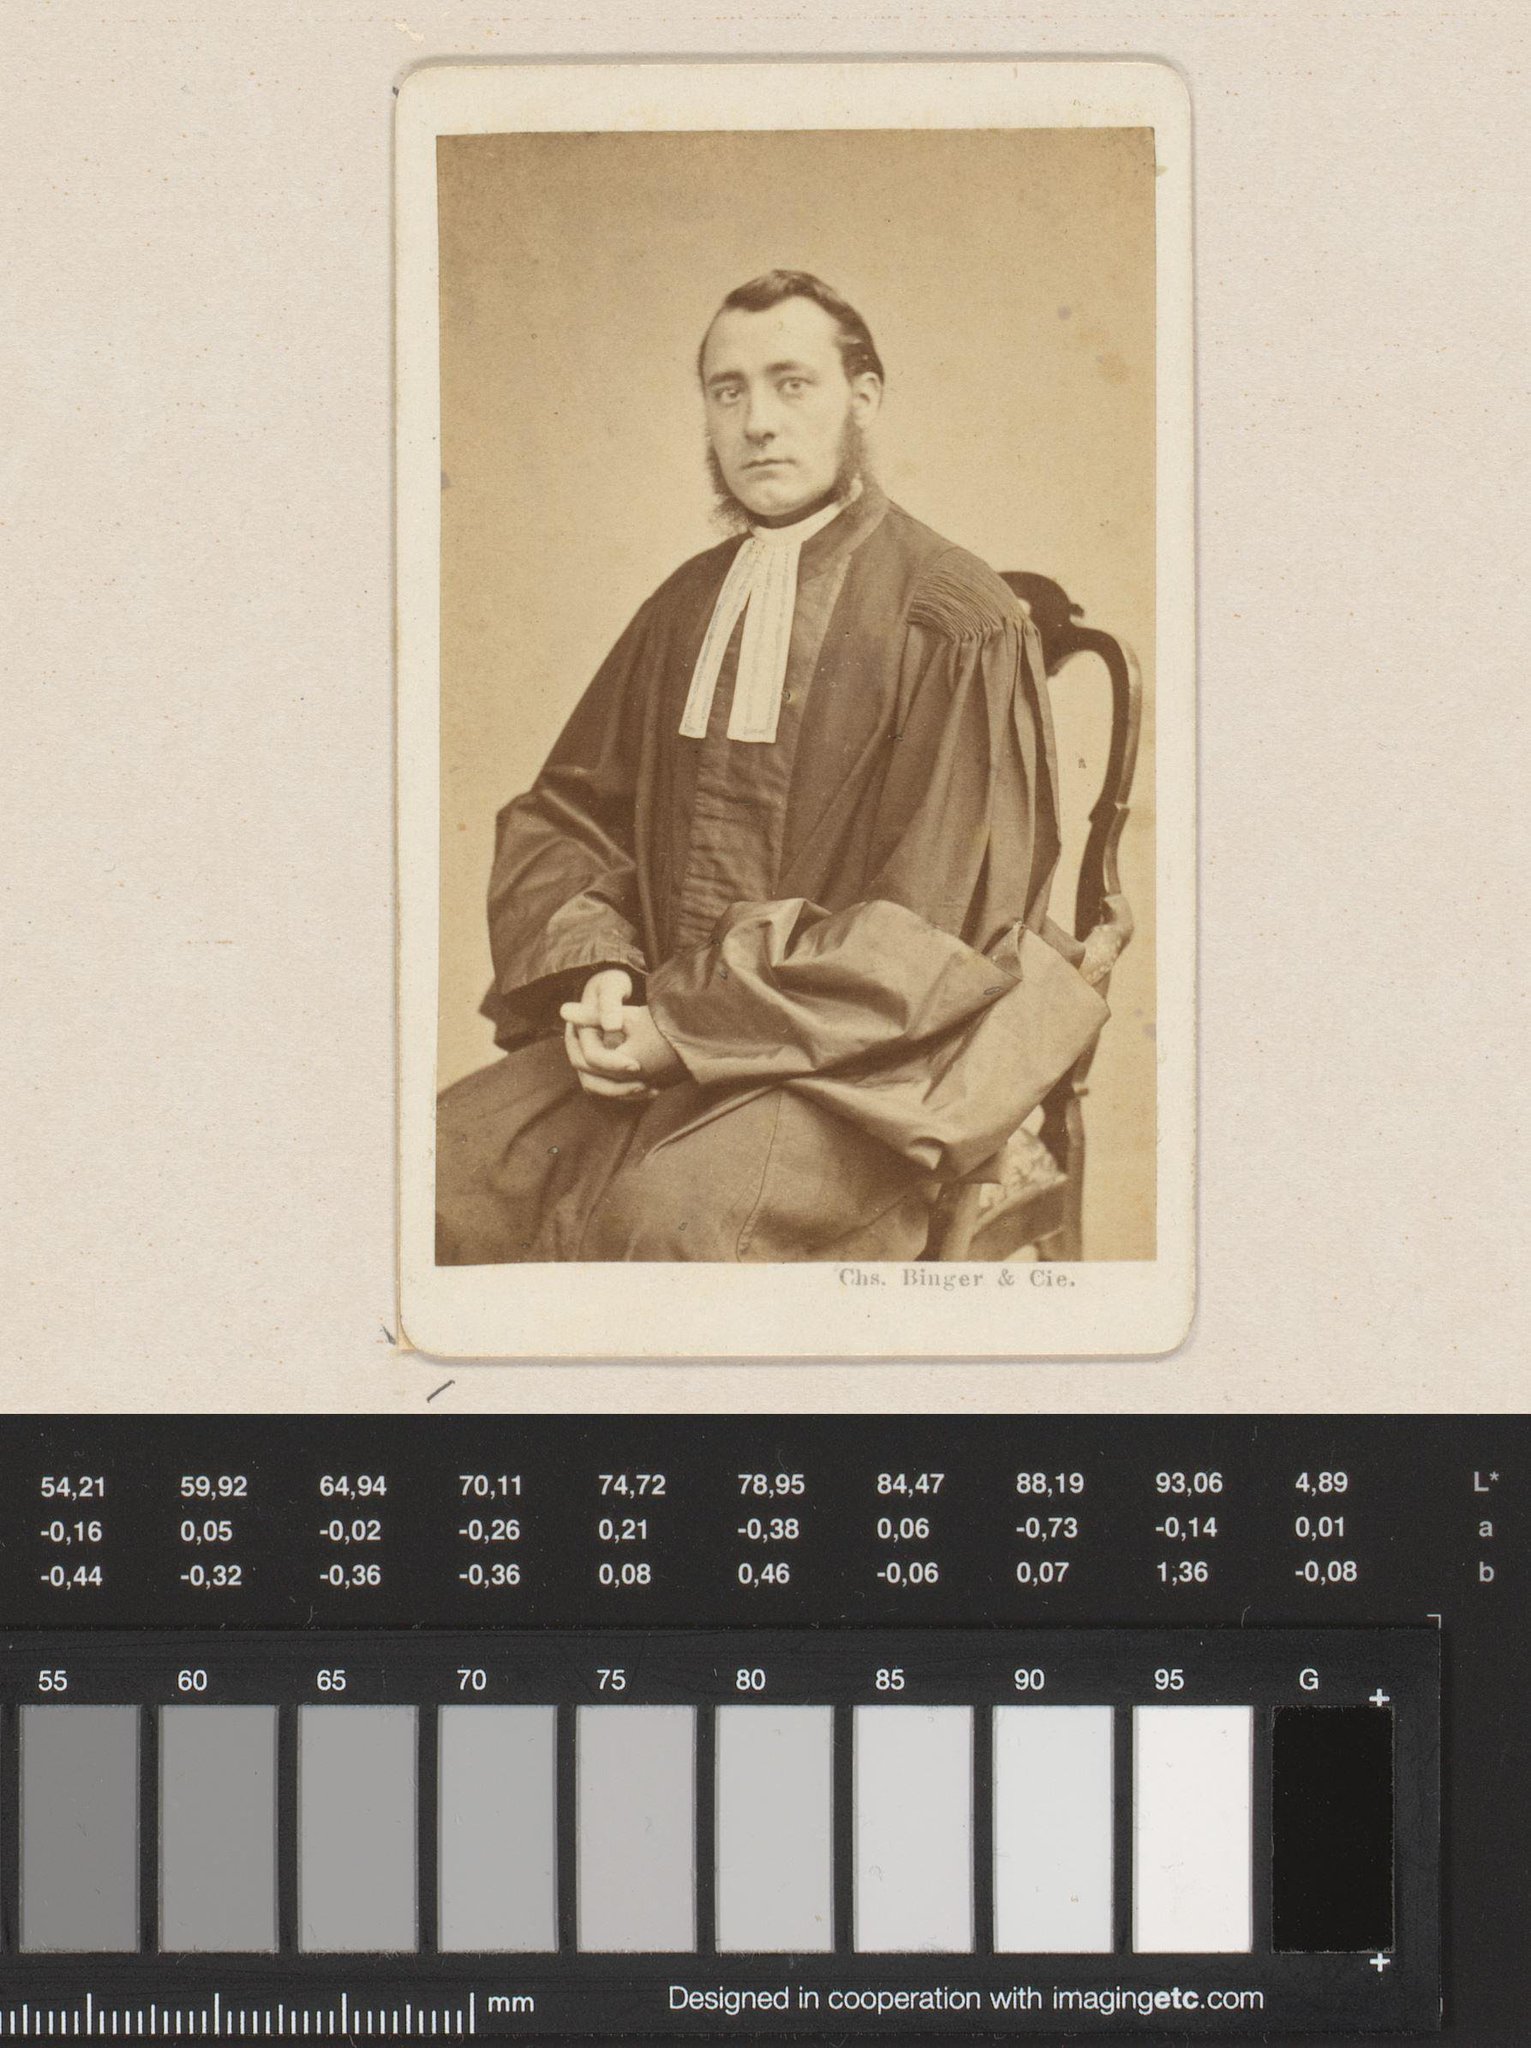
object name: carte de visite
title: Portret van H. Laatsman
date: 1862-1882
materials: cardboard, paper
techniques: albumen print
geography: haarlem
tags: historical persons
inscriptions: address: ‘Chs. Binger & Cie./ Zijlstraat/ HAARLEM.’